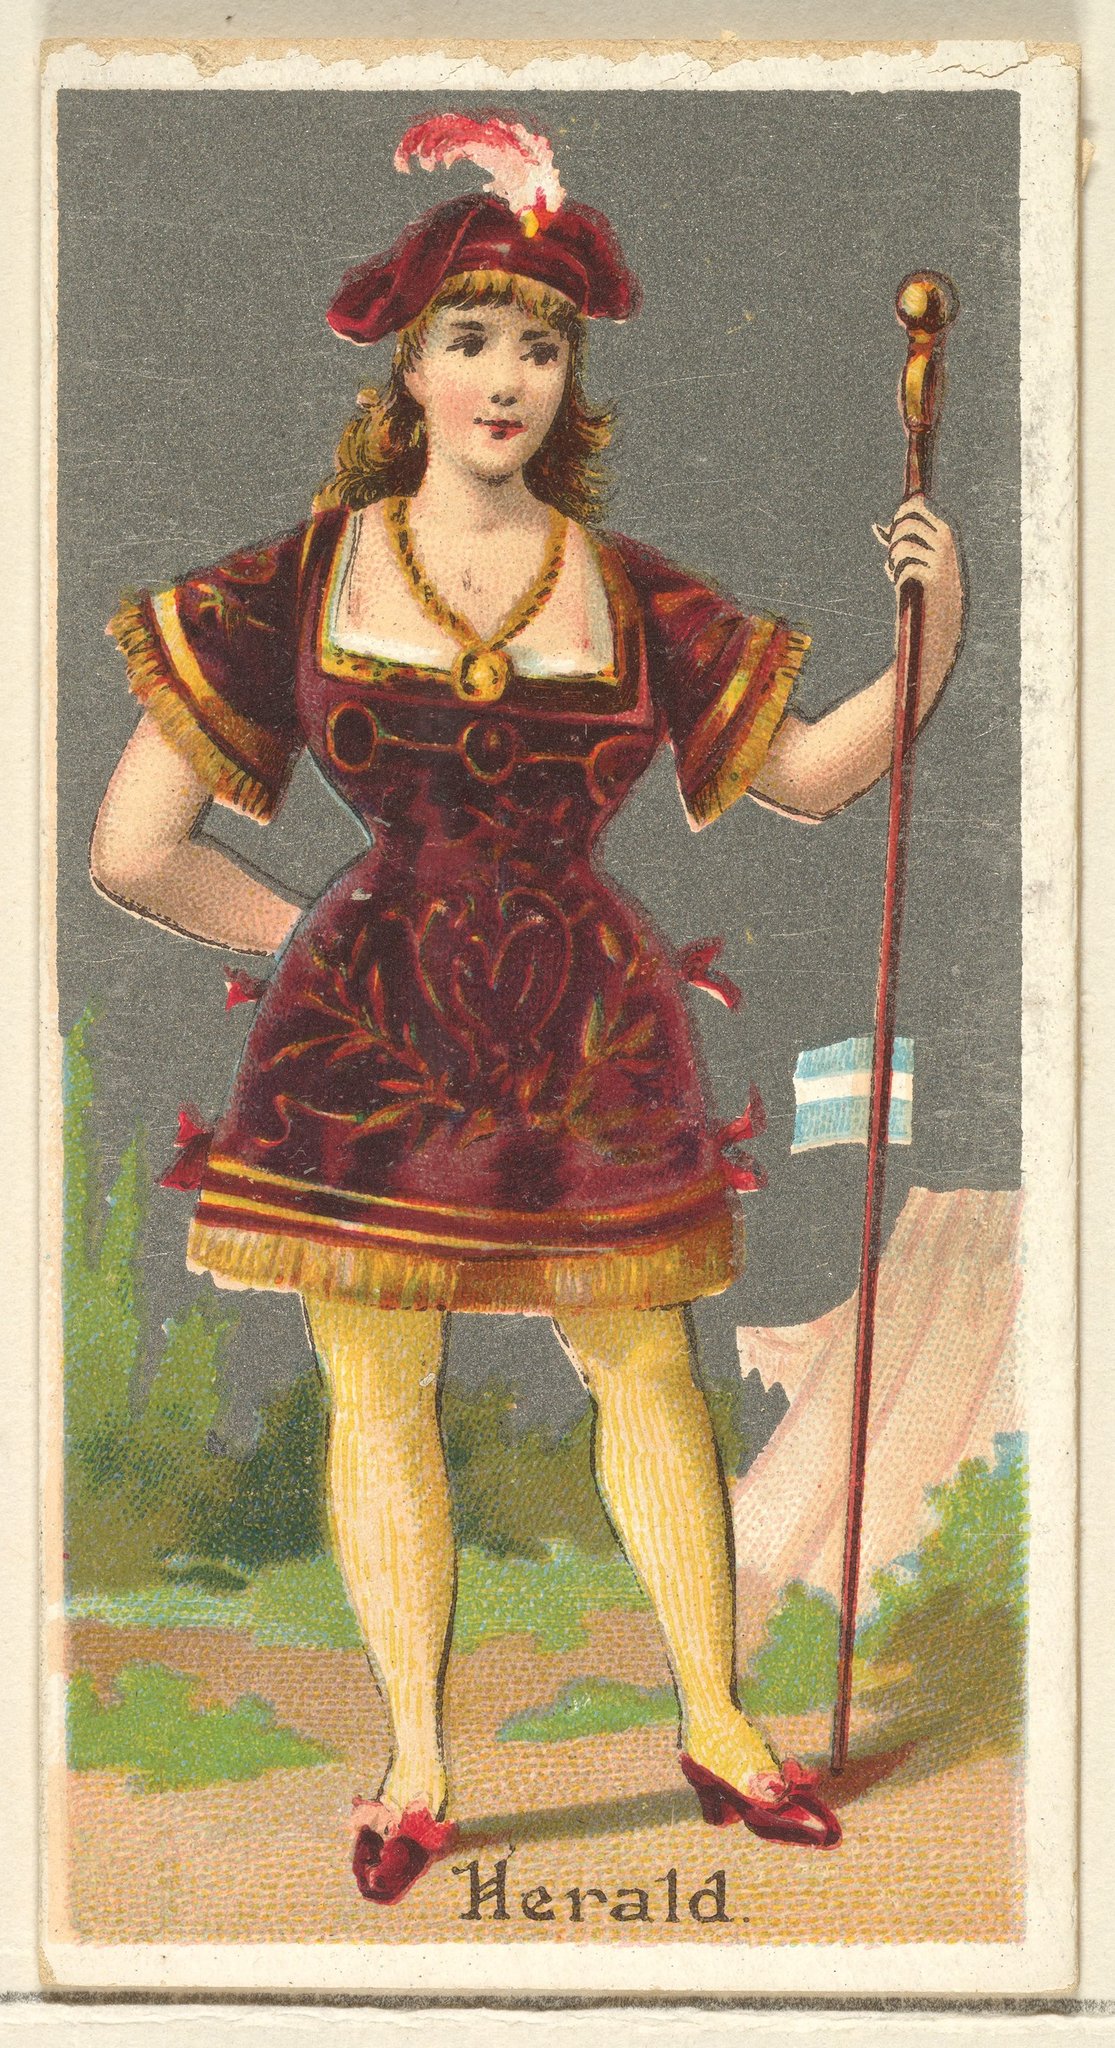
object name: print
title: Herald, from the Occupations for Women series (N166) for Old Judge and Dogs Head Cigarettes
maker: goodwin & company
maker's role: publisher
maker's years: 1850-1950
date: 1887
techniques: color lithograph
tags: women